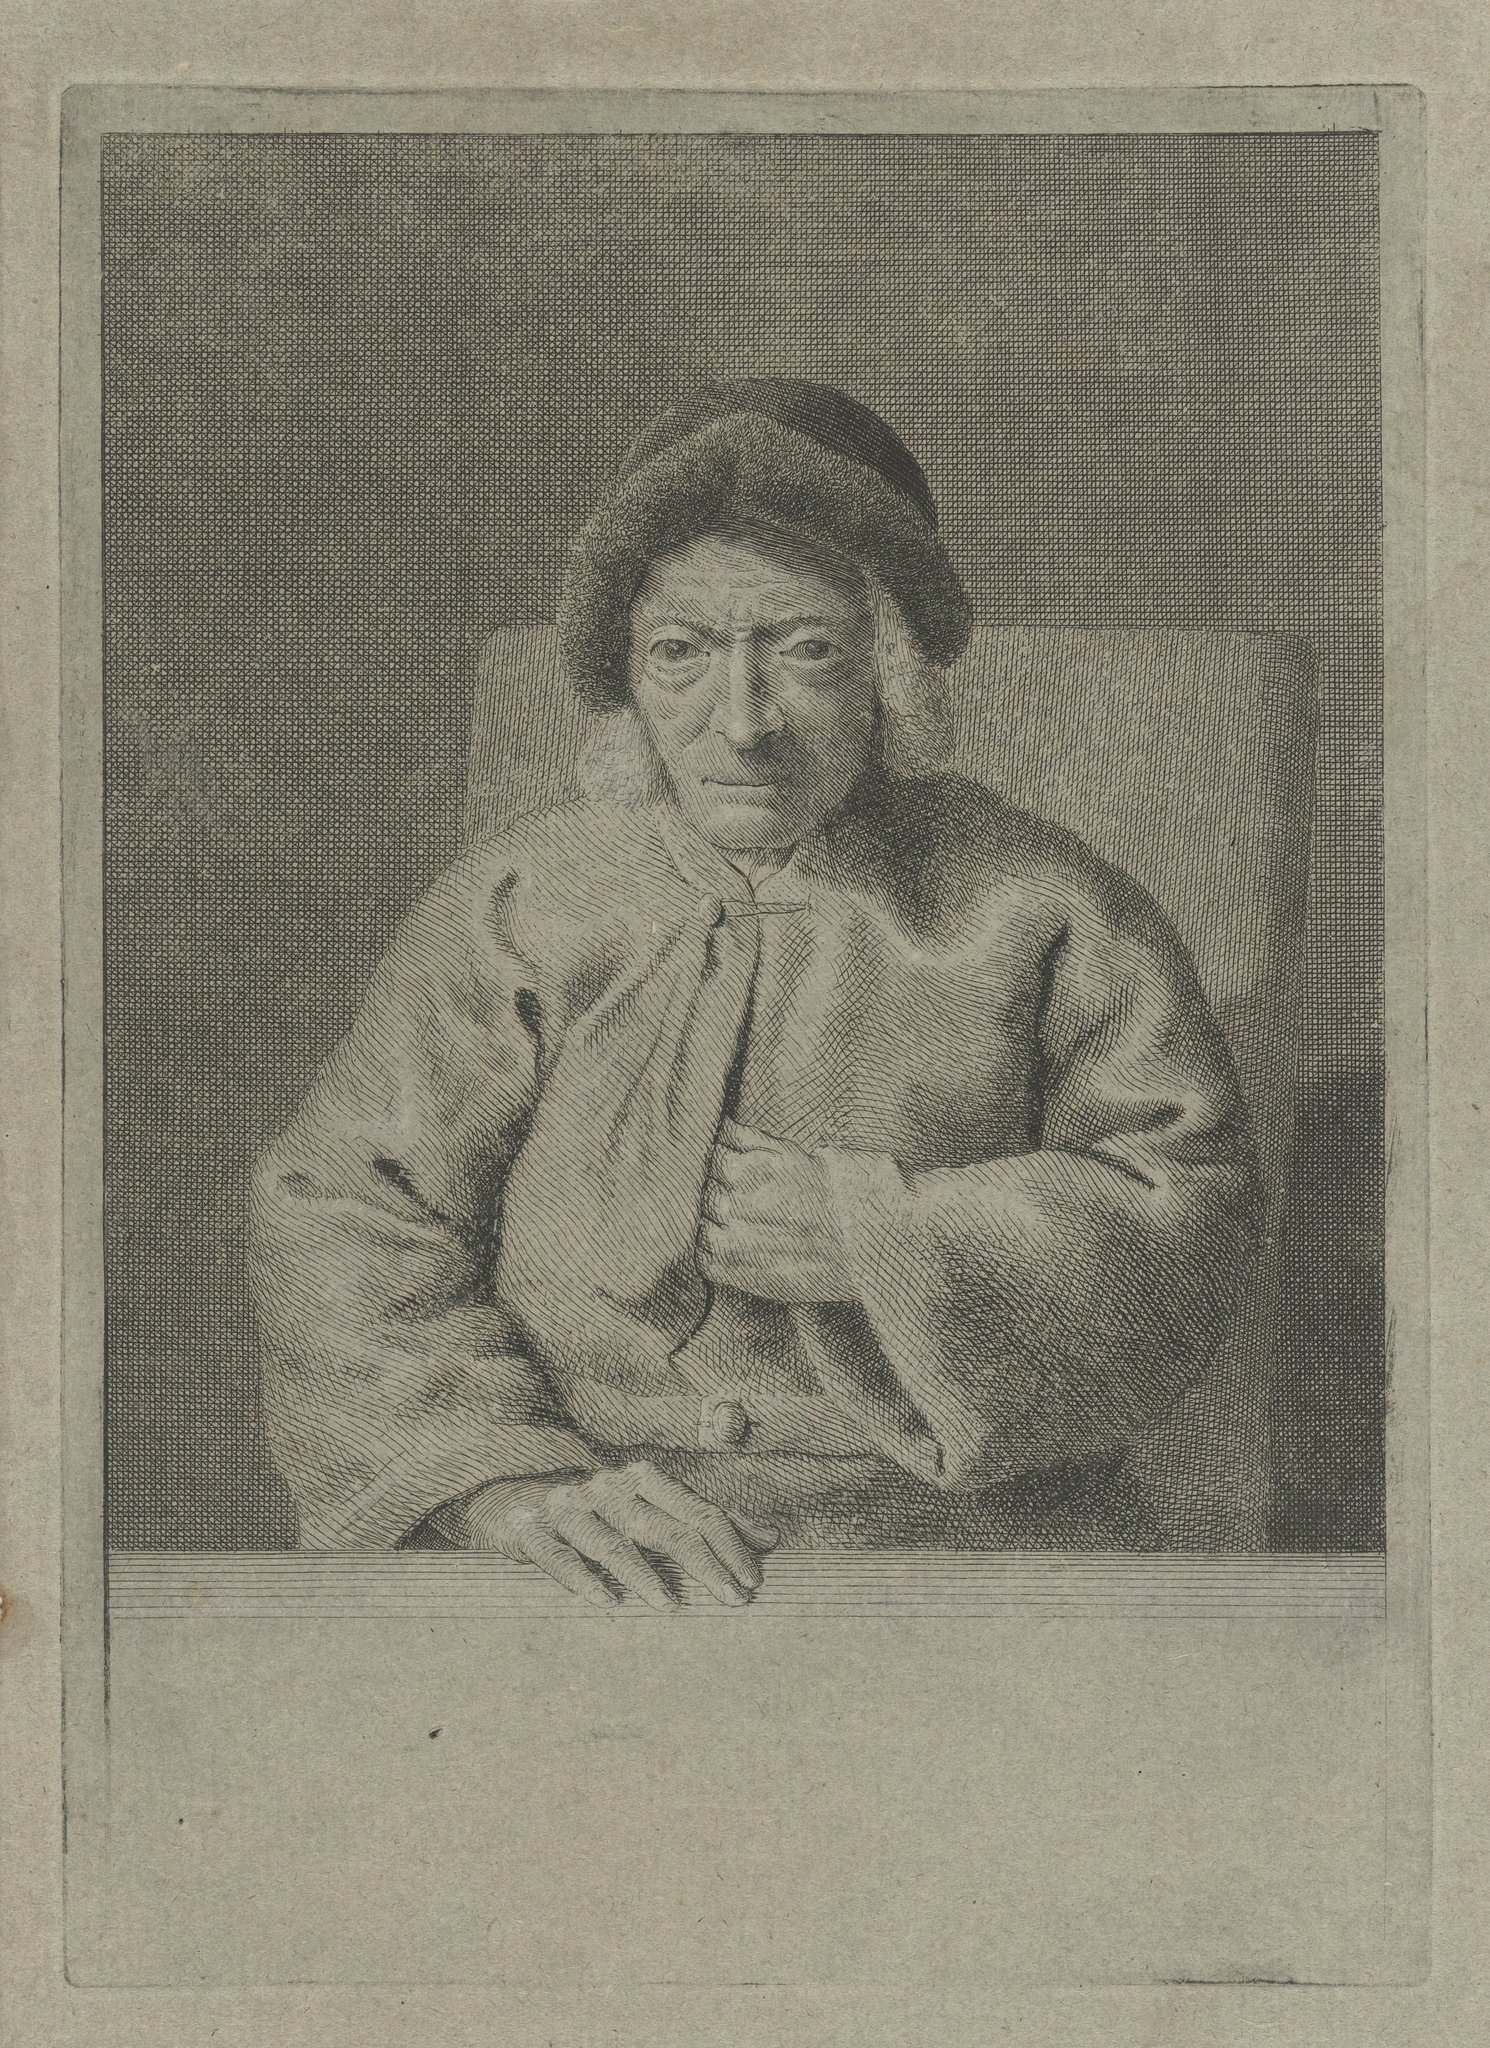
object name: print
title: Portret van Hendrik Tilly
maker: cornelis van noorde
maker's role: draughtsman, print maker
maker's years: 1731-1795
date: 1764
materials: paper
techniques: engraving, etching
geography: haarlem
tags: hendrik tilly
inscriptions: collector's mark: Lugt 2228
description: Portret van Hendrik Tilly op 102-jarige leeftijd. Hij woonde in het Aalmoezeniershuis van Haarlem.